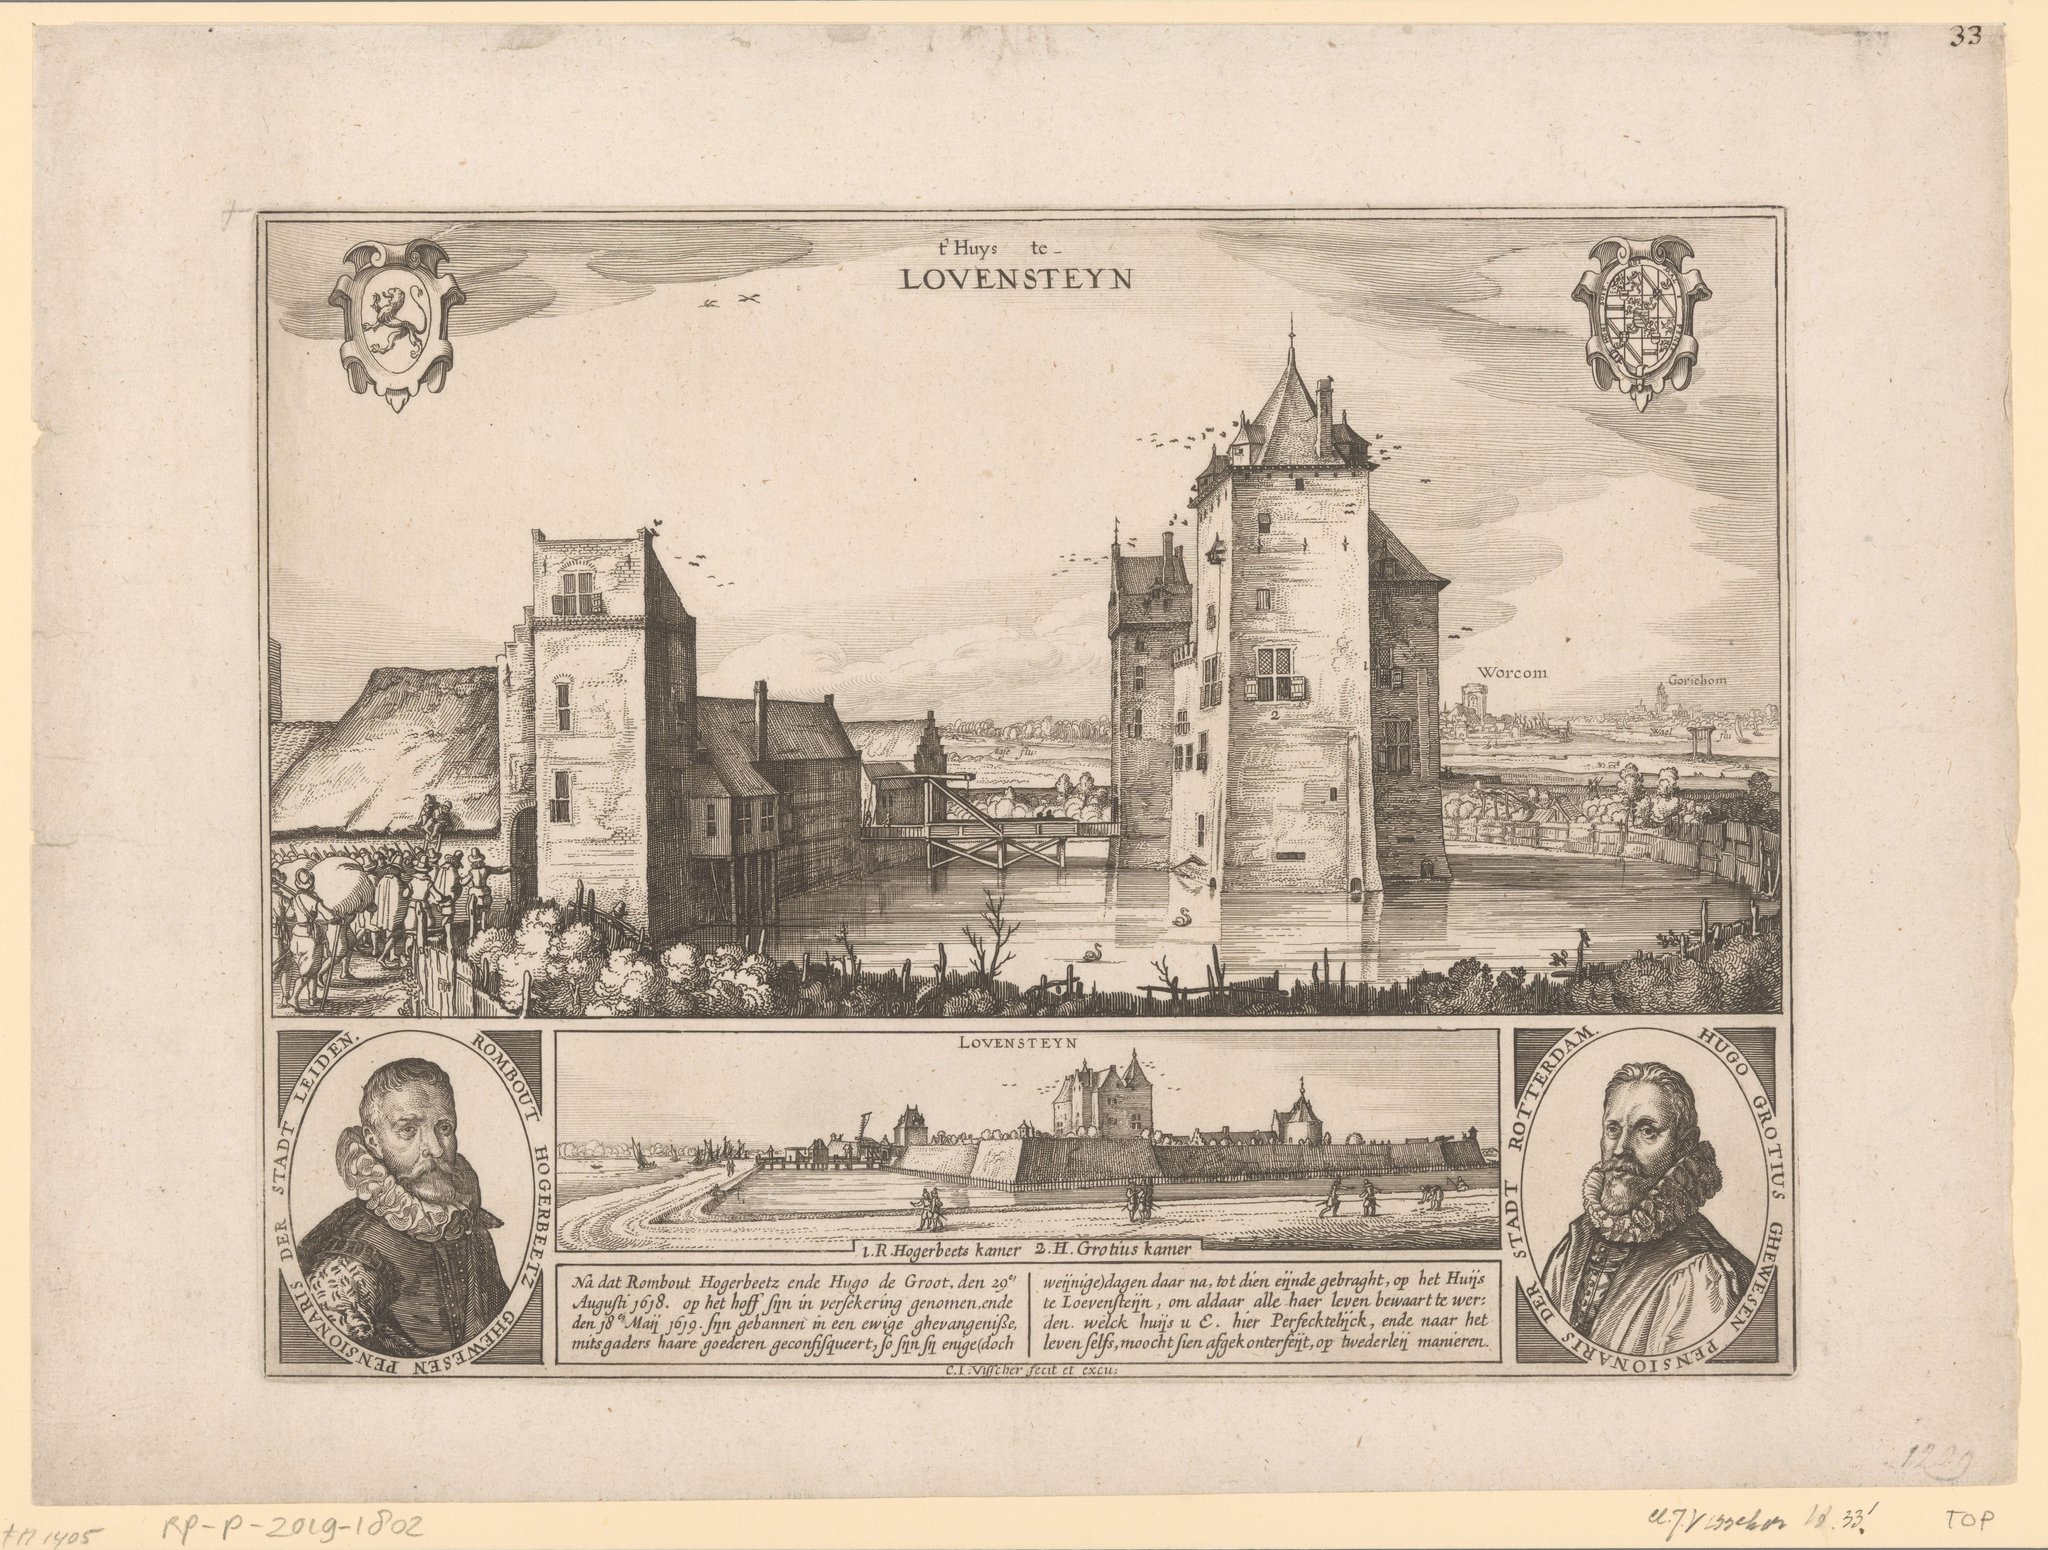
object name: print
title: t'Huys te Lovensteyn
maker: claes jansz. visscher (ii)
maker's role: draughtsman, print maker, publisher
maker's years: 1586-1652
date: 1619-1621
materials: paper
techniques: engraving, etching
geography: amsterdam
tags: delft, hugo de groot, hoorn (north holland), castle, imprisonment, loevestein castle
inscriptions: inscription: ‘33’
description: Gezicht op Slot Loevestein. Rombout Hogerbeets en Hugo de Groot waren beiden op 18 mei 1619 tot levenslange opsluiting in het kasteel veroordeeld. Linksboven het wapen van Holland, rechtsboven dat van Maurits van Oranje. Links de aankomst van de gevangenen begeleid door soldaten. In de verte de steden Woudrichem en Gorinchem. Onderaan twee portretten van de veroordeelden en een tweede gezicht op Loevestein met een korte beschrijving van gebeurtenis.